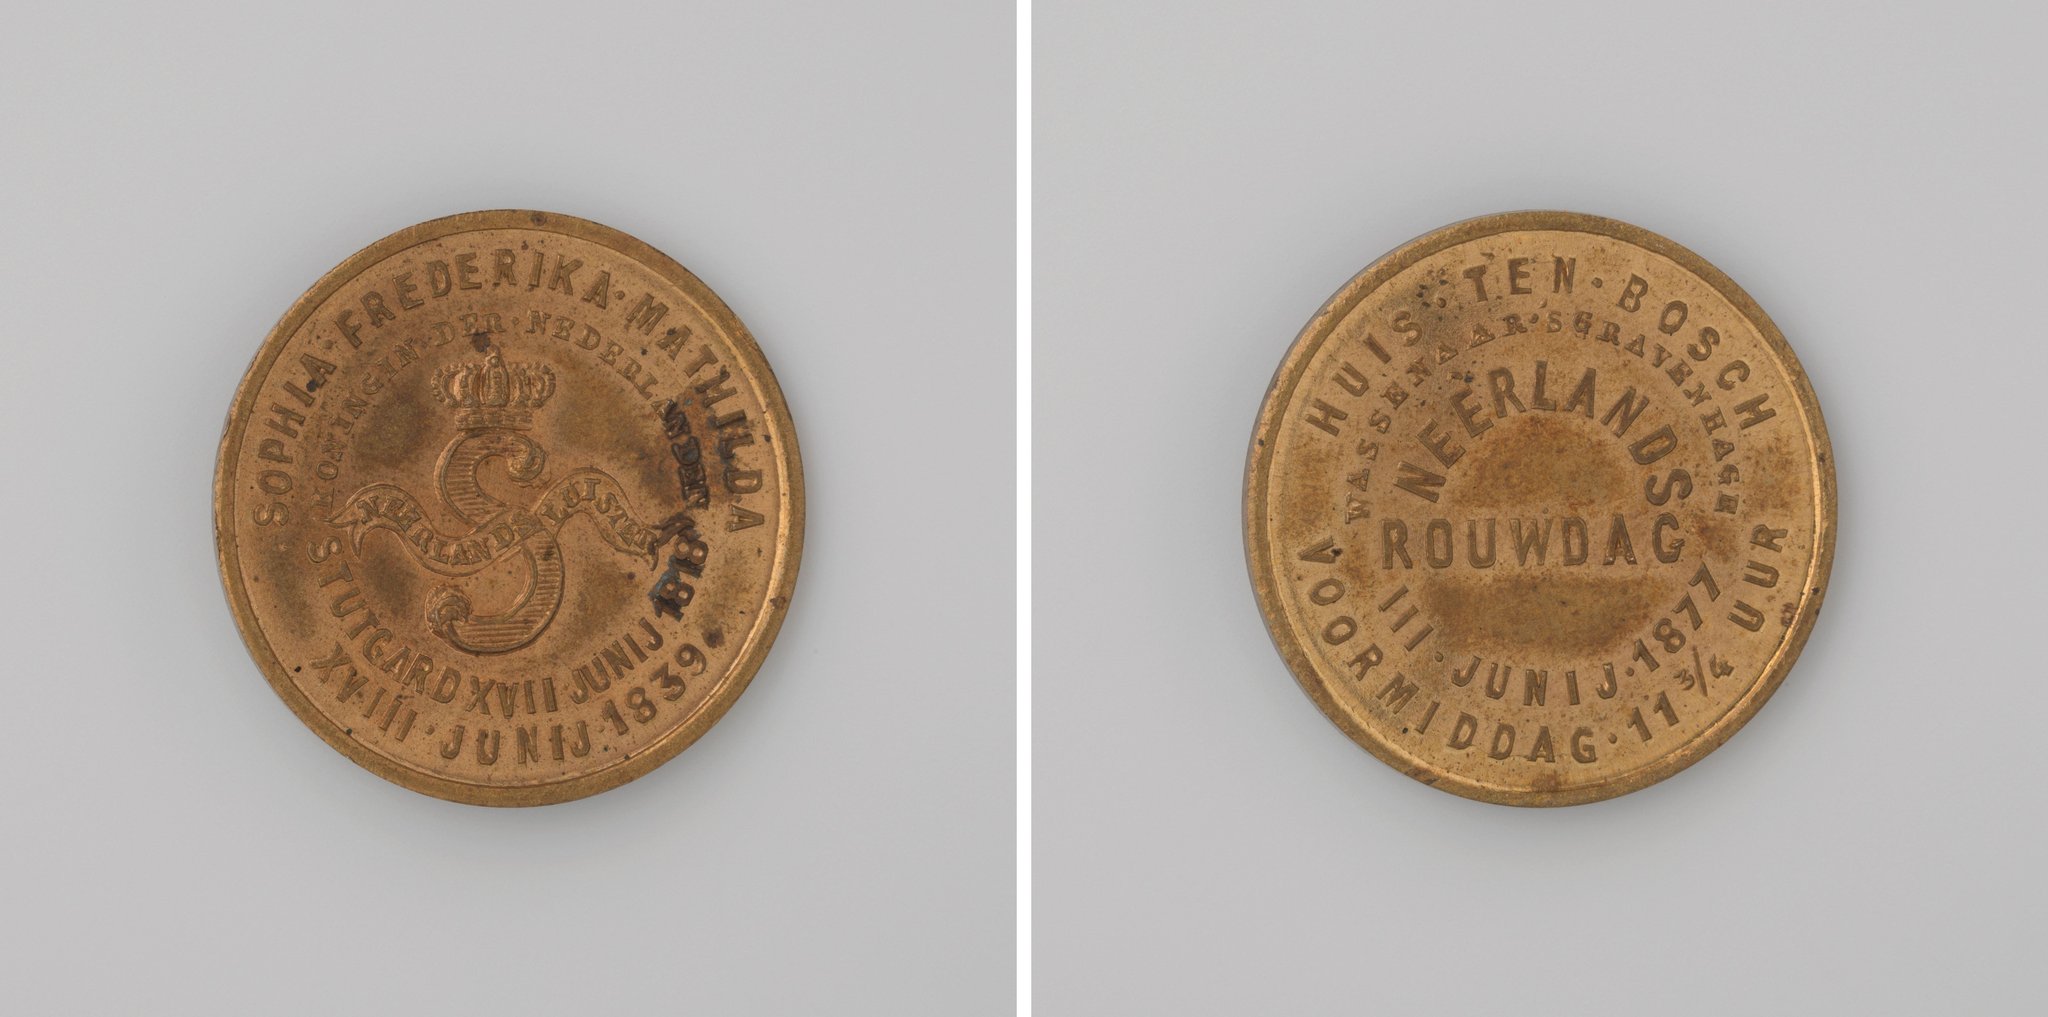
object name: history medal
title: Overlijden van Koningin Sophia der Nederlanden 1877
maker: salomon de vries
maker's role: graveur, medailleur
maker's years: 1830-1899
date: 1877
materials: brass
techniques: striking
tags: sophia frederika mathilda van württemberg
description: Messing penning, op de voorzijde een gekroonde letter S waarover een banderol met NEERLANDS LUISTER, met dubbel omschrift, op de keerzijde het opschrift NEERLANDS ROUWDAG met dubbel omschrift.